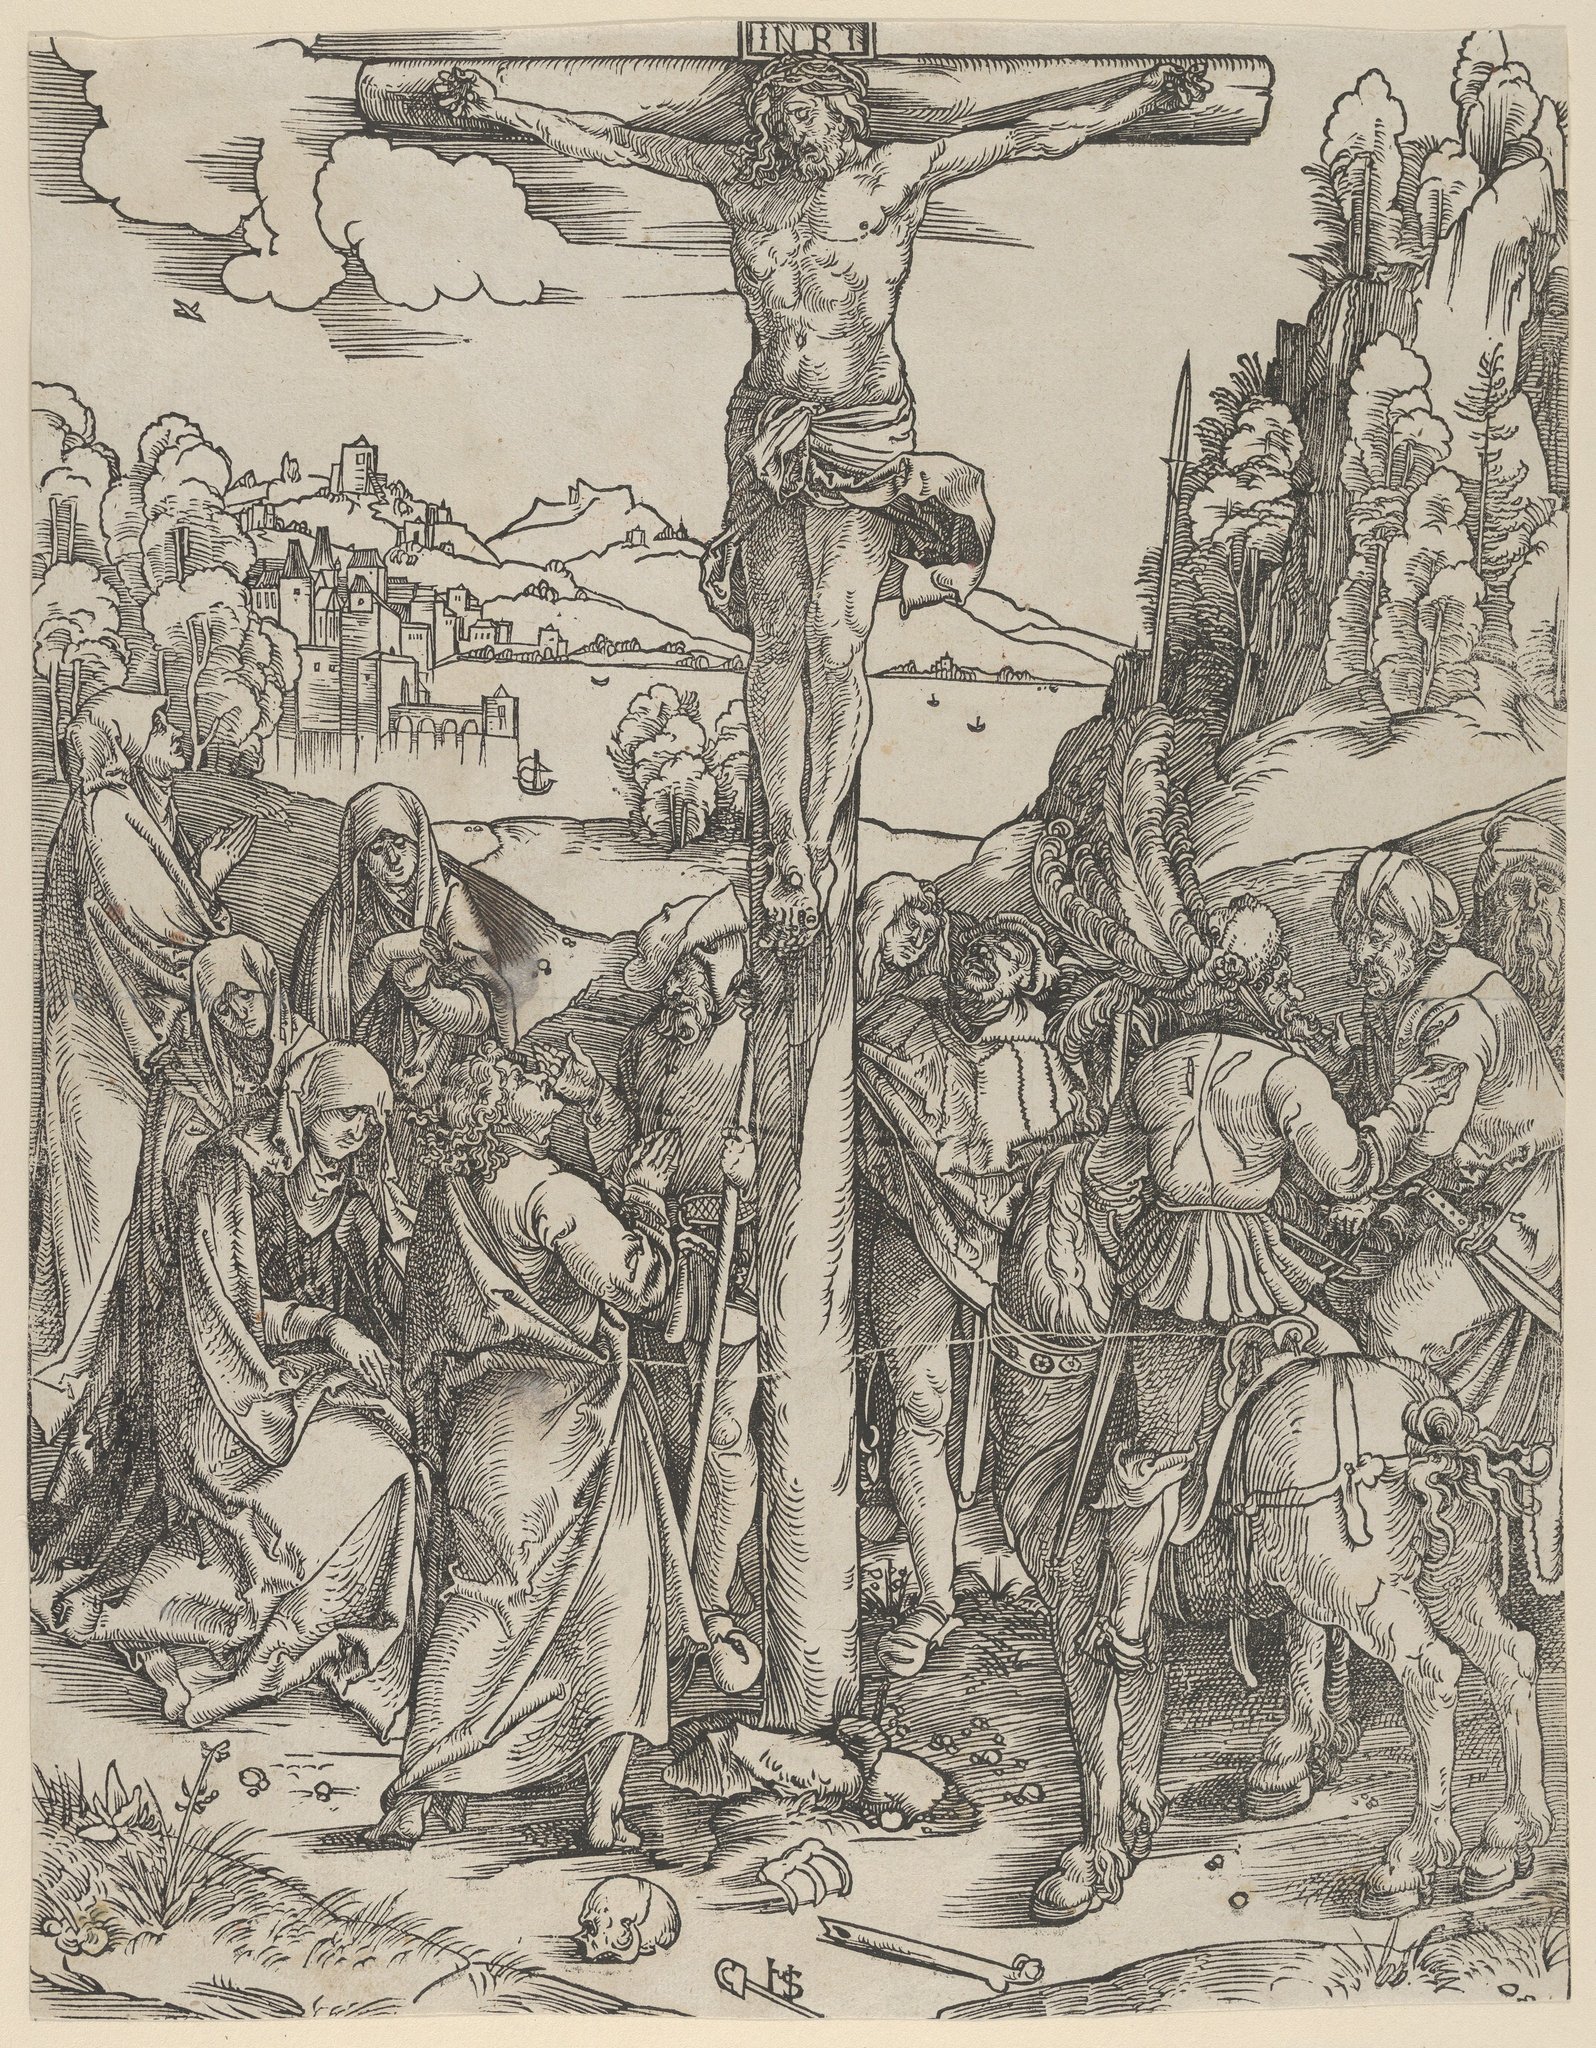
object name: print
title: Christ at the Cross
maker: hans schäufelein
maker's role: artist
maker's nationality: german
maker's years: 1480-1540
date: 1506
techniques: woodcut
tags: human figures,horses,christ,crucifixion